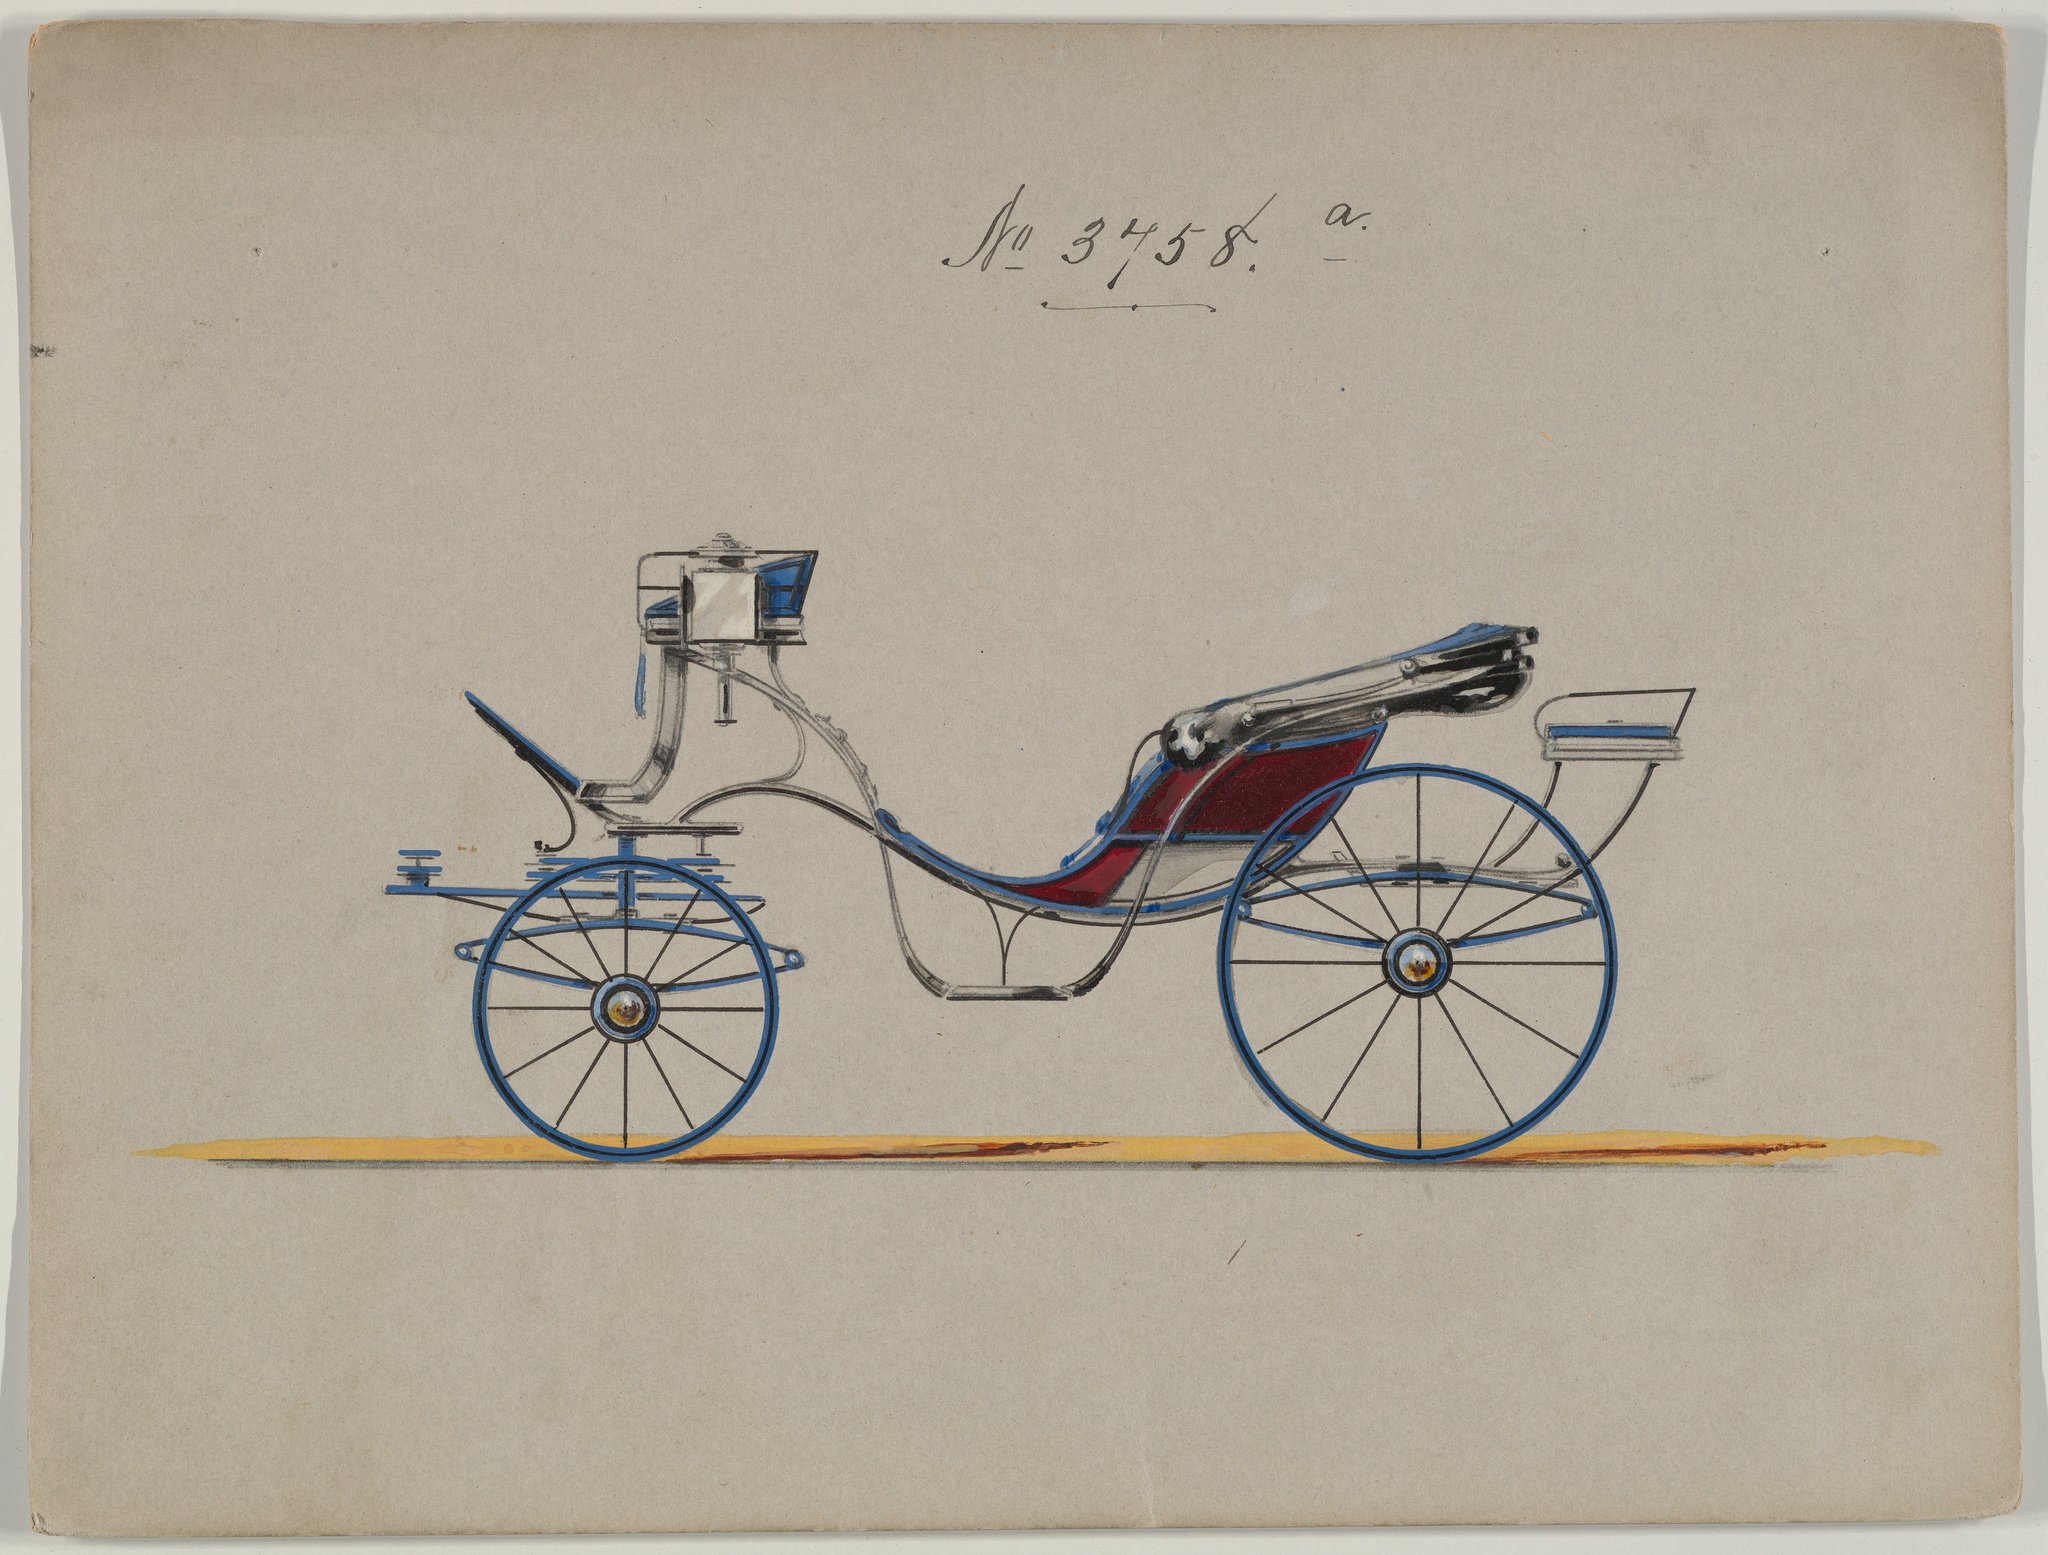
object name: drawing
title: Design for Cabriolet or Victoria, no. 3758a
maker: brewster & co.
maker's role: manufacturer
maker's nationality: american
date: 1882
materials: ink, watercolor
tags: carriages